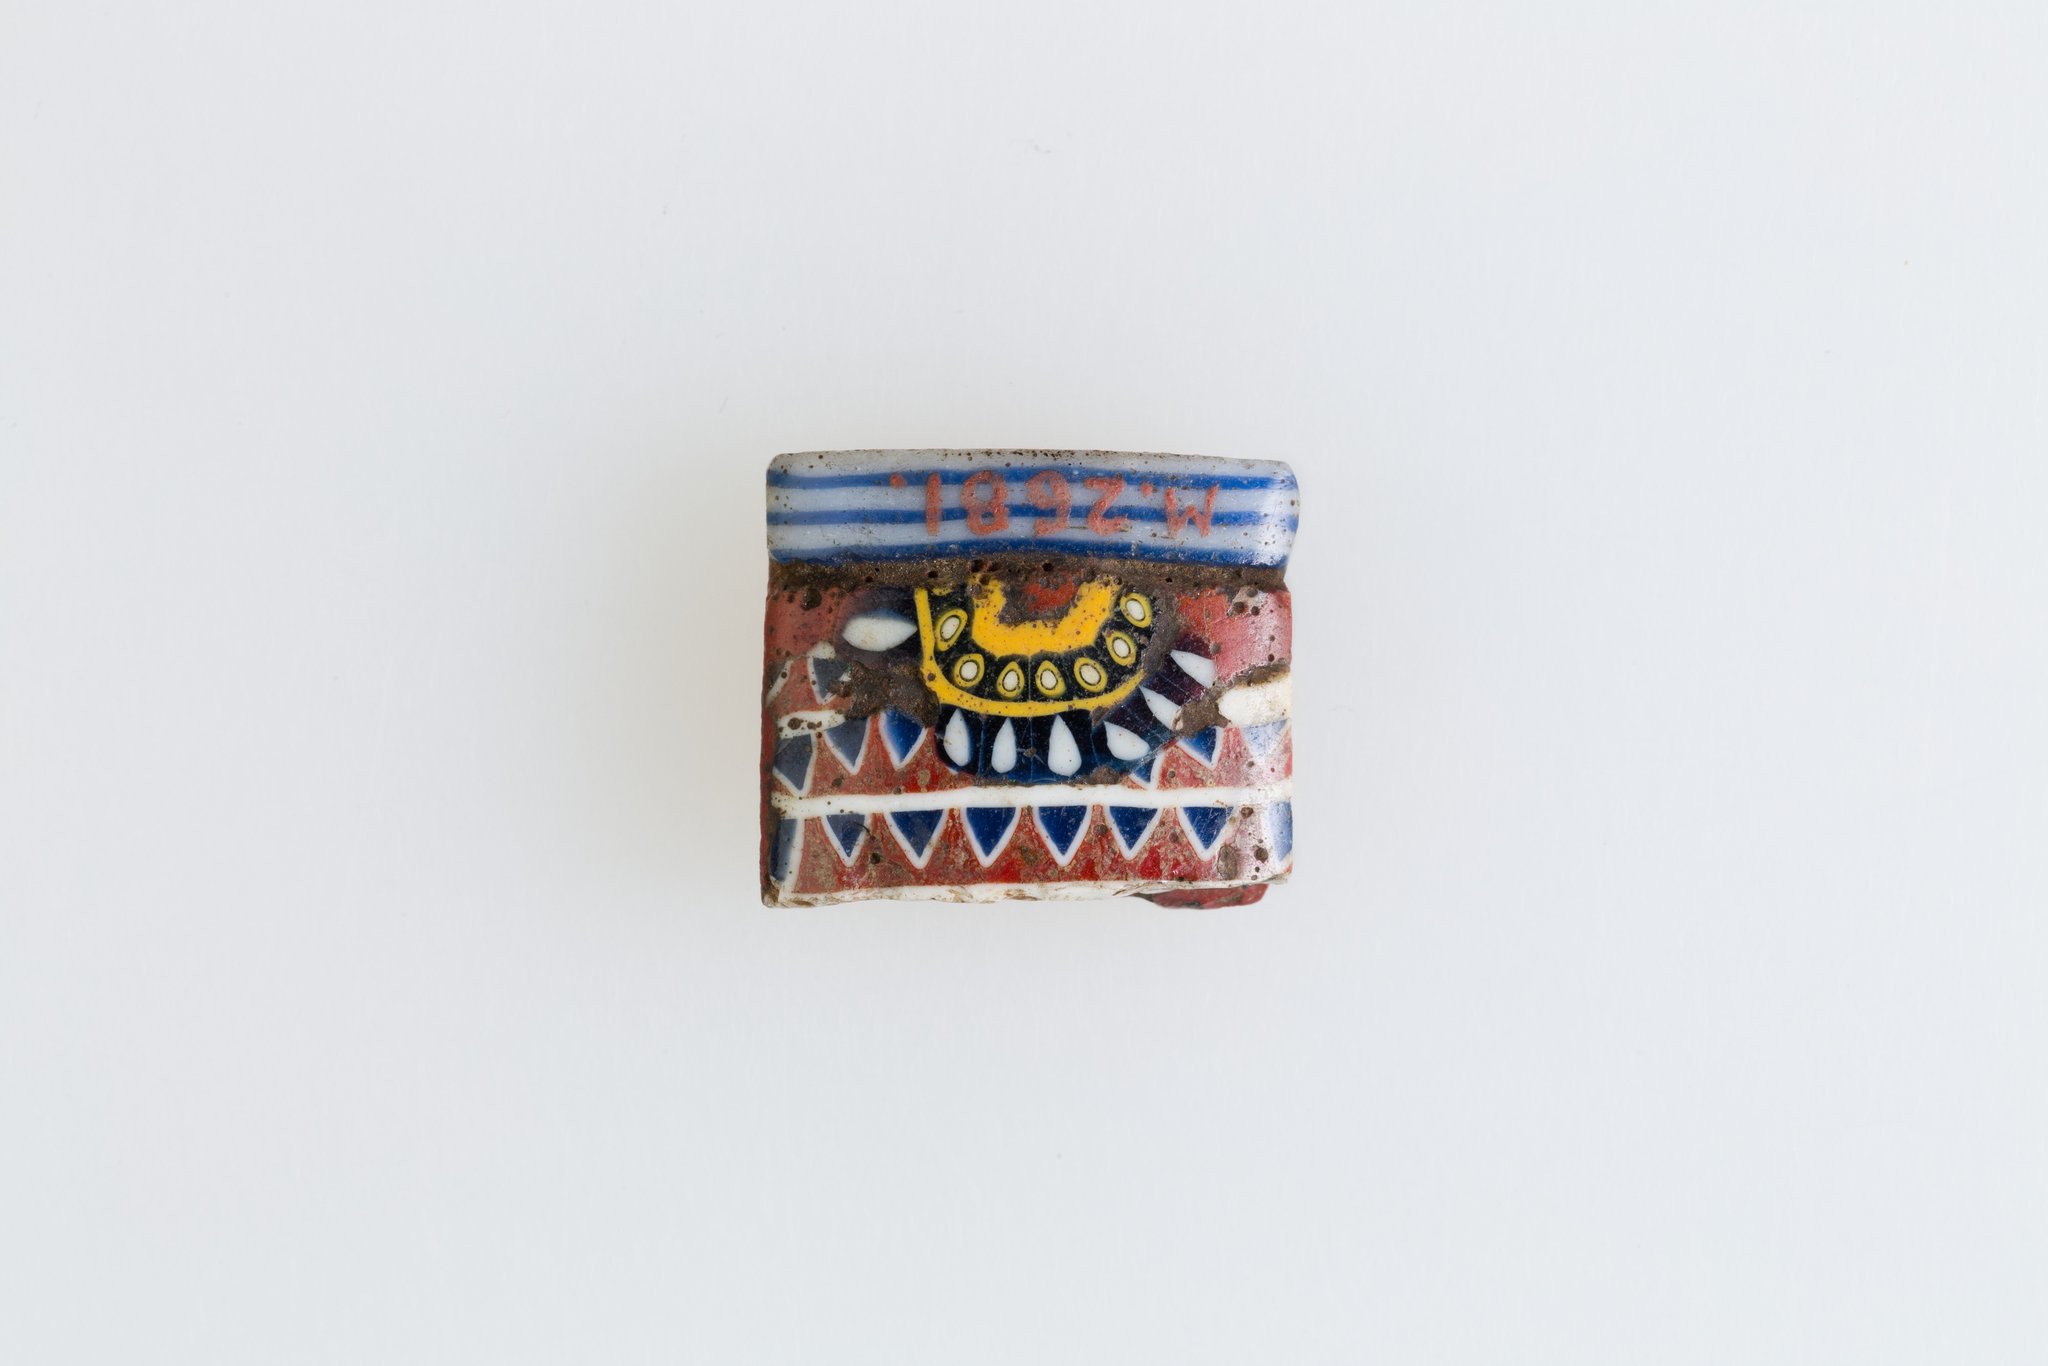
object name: inlay fragment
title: Inlay fragment, collar design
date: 100 BCE-100 CE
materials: glass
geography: egypt